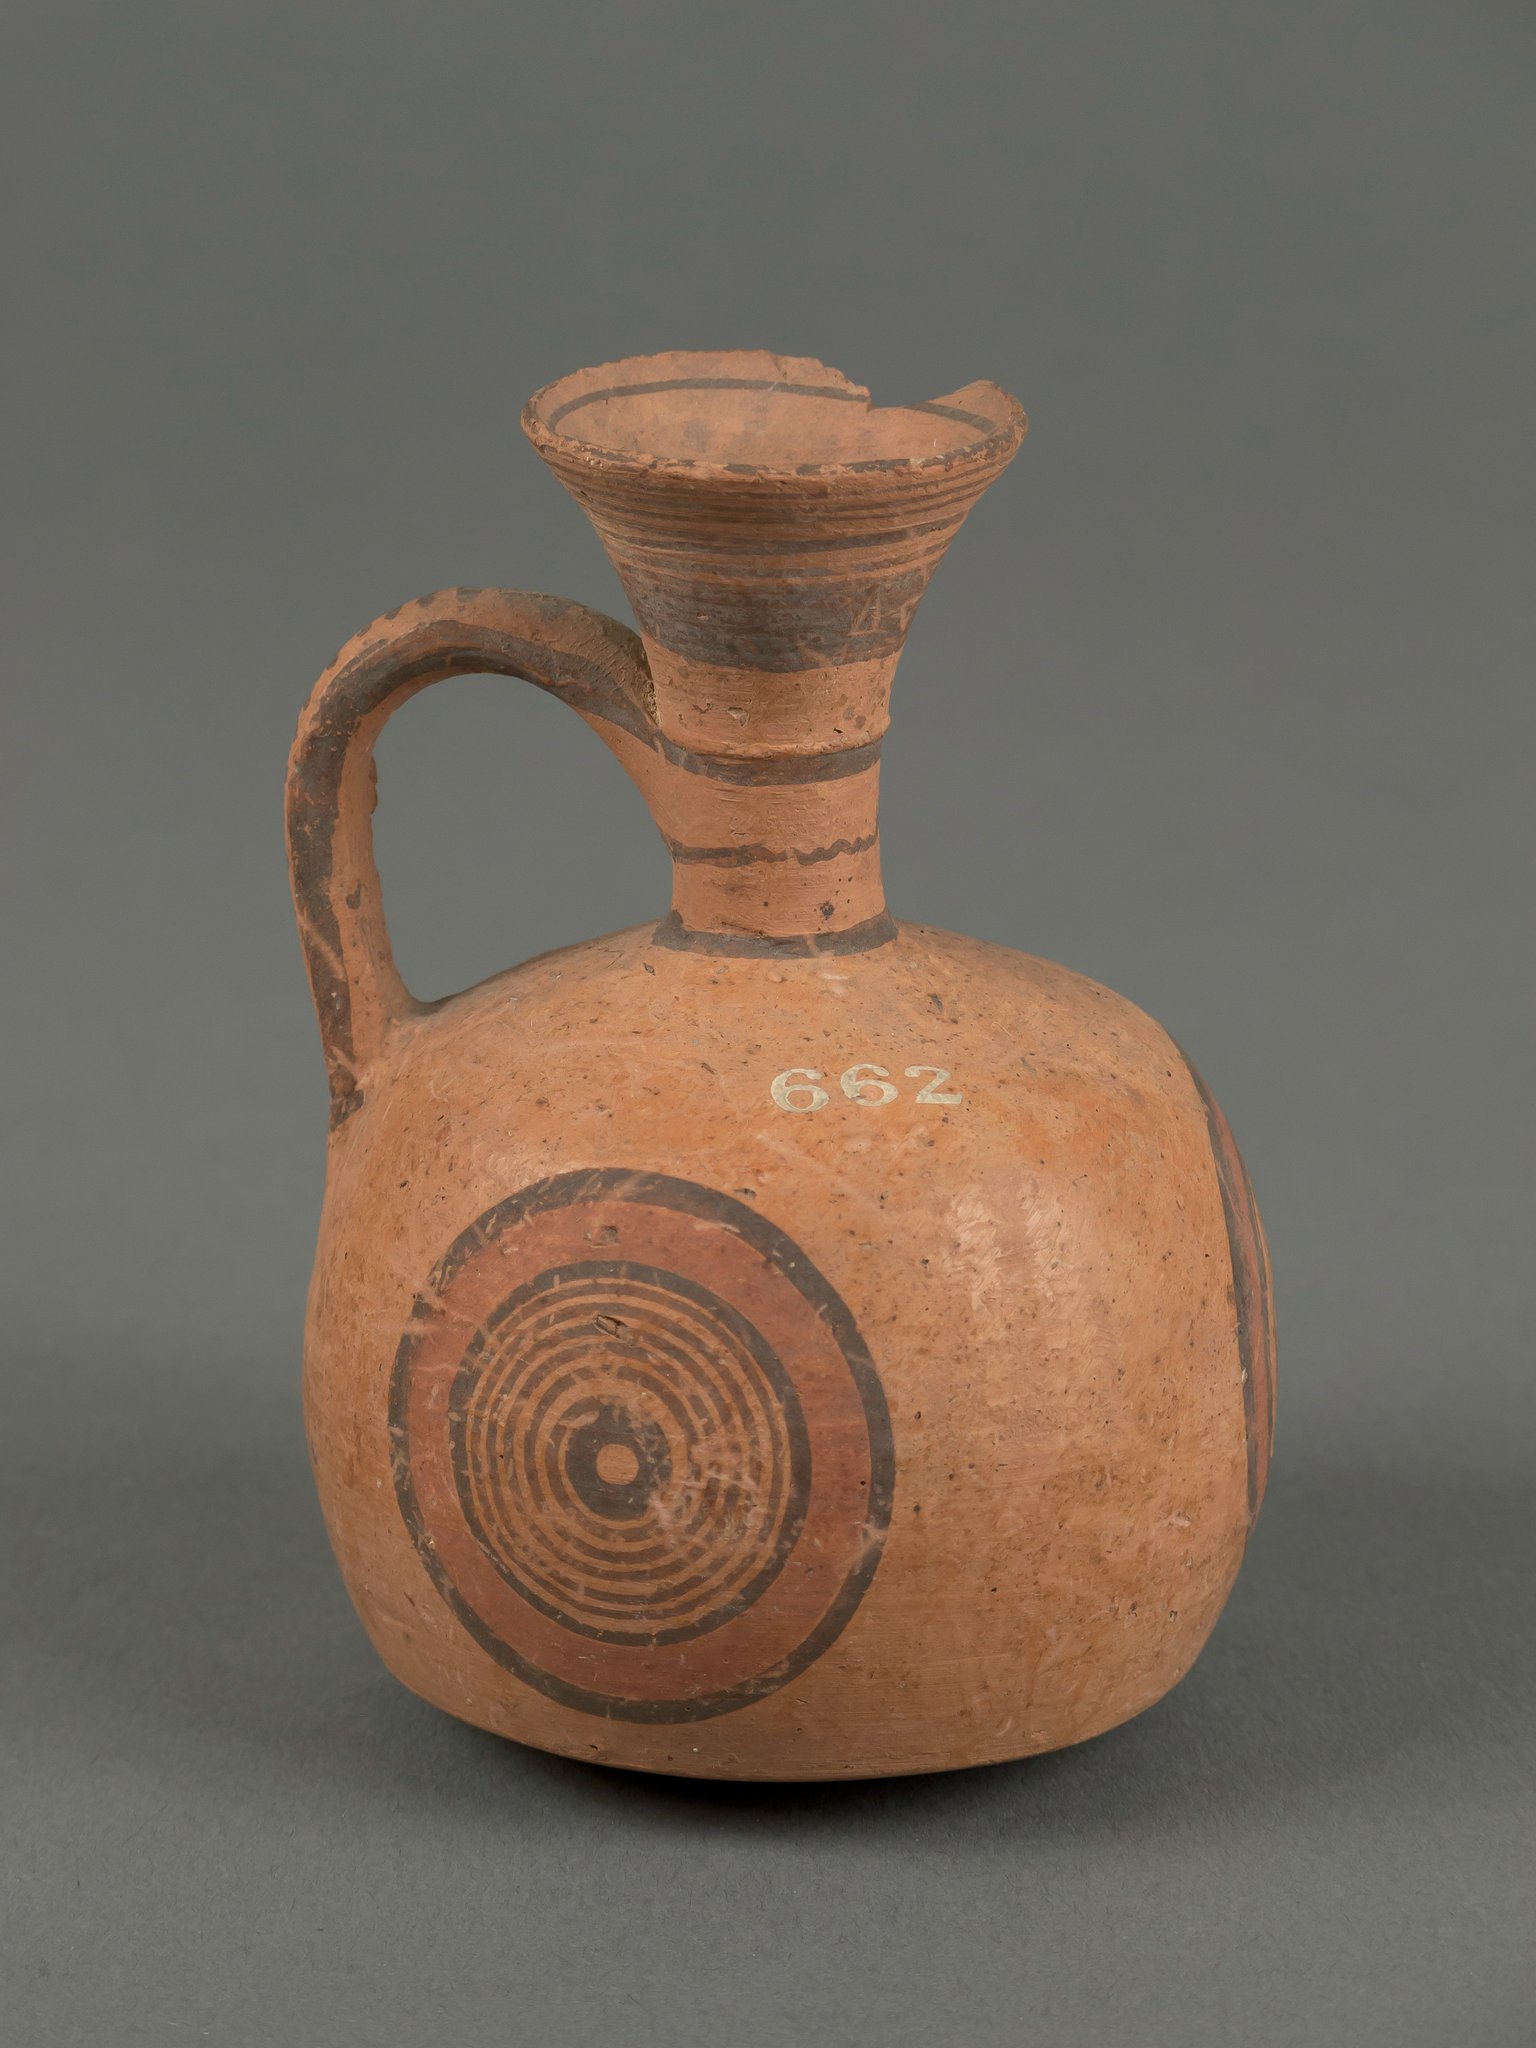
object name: juglet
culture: cypriot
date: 850-750 BCE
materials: terracotta